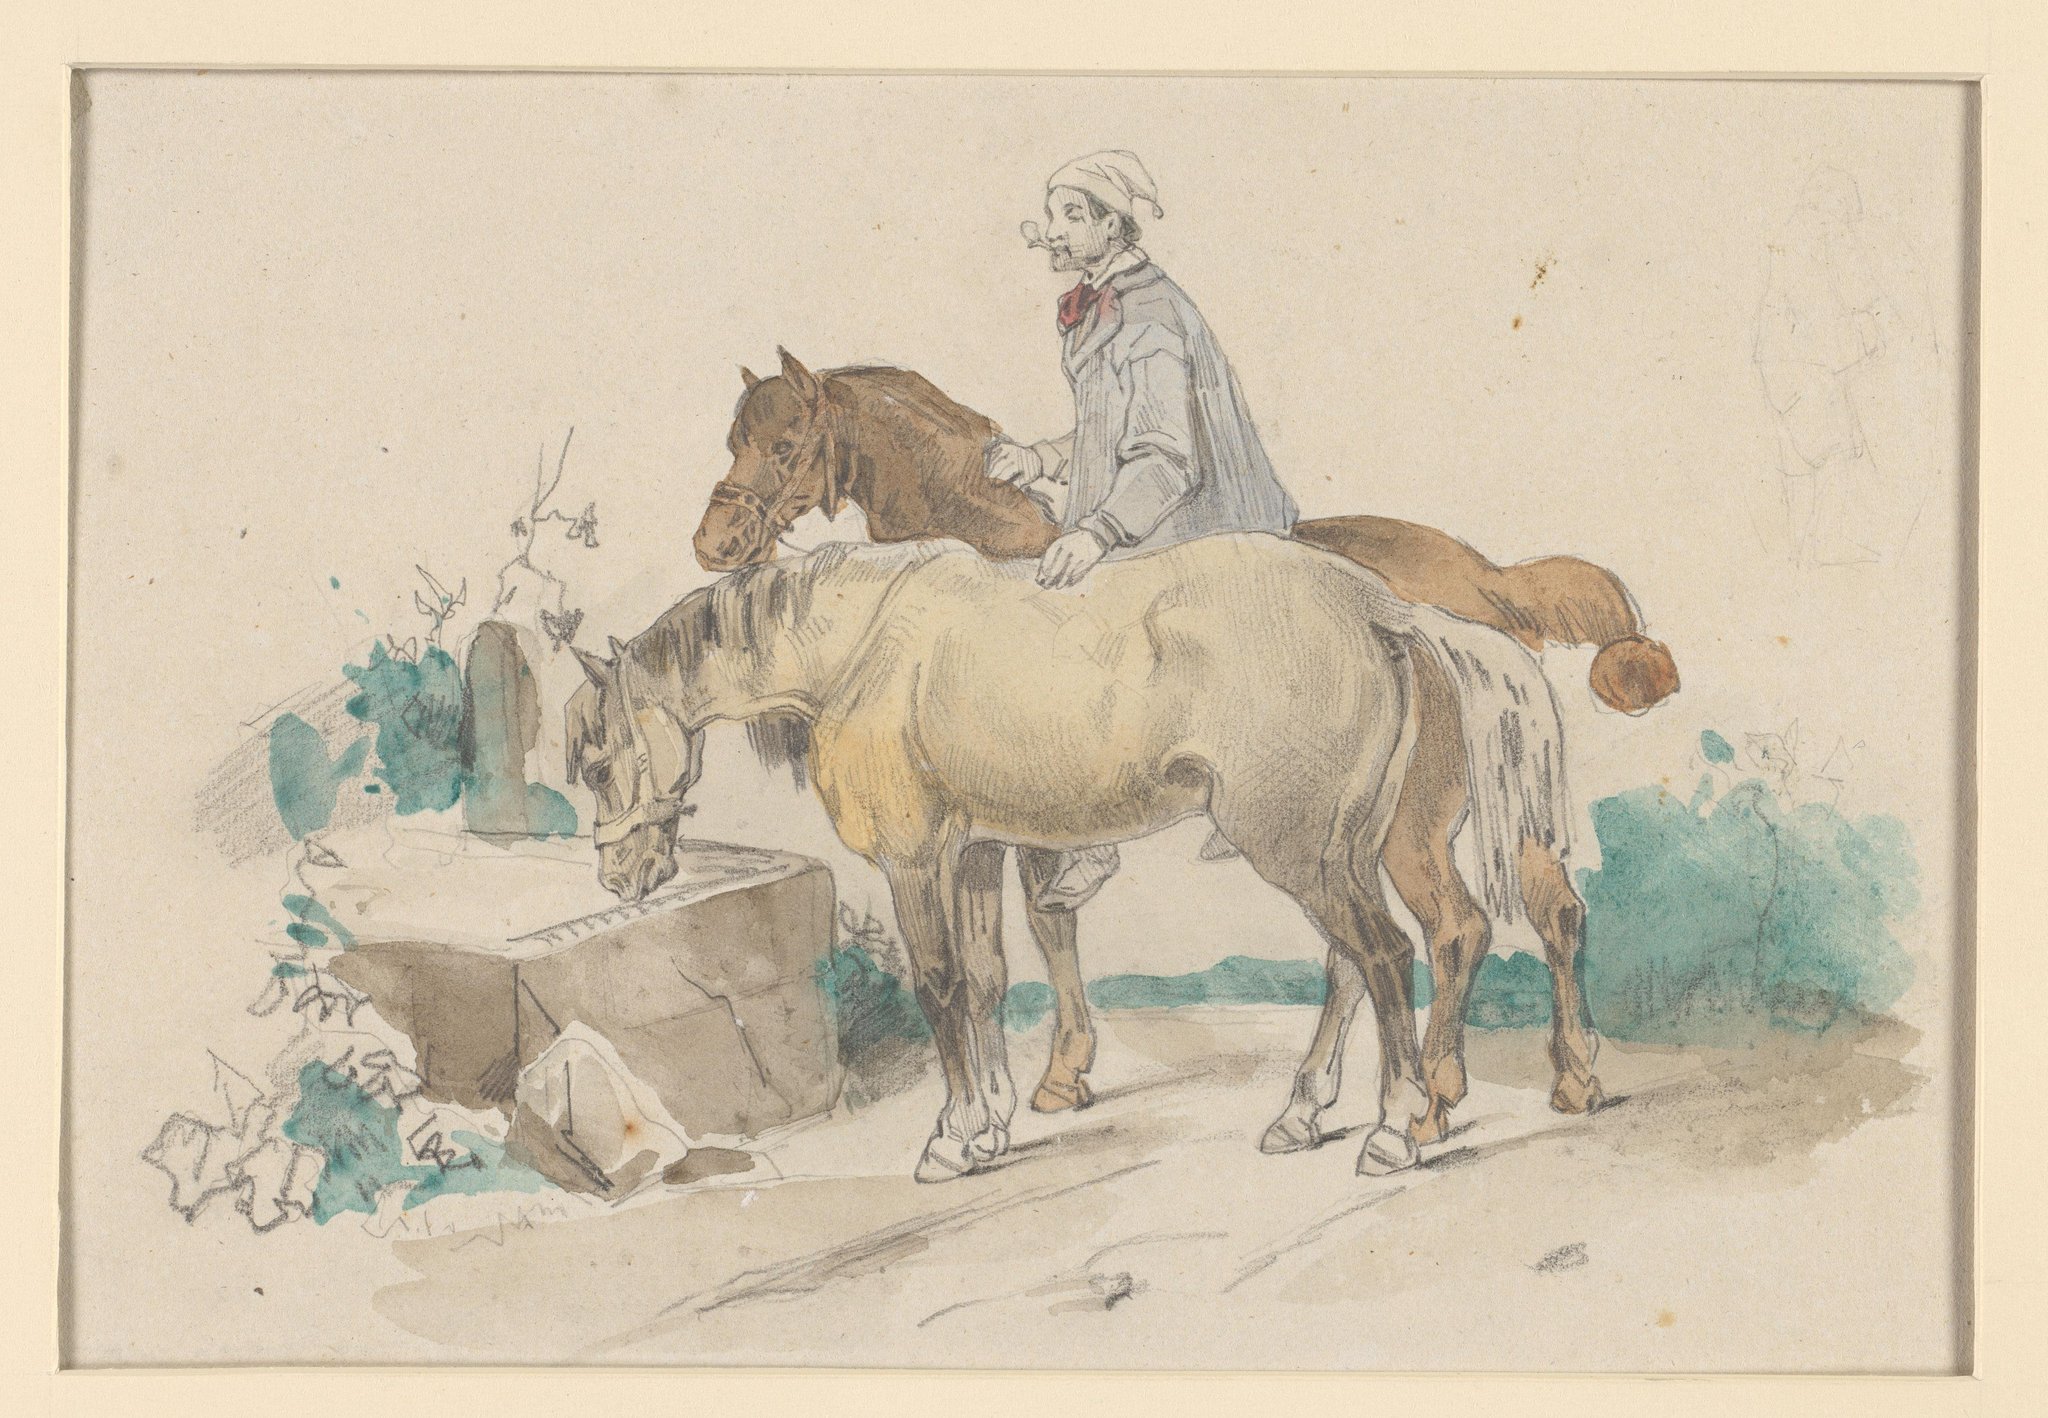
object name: drawing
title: Boer met twee paarden bij een trog met water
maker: jan weissenbruch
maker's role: painter, print maker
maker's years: 1822-1880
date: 1832-1880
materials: paper, pencil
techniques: brush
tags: horse